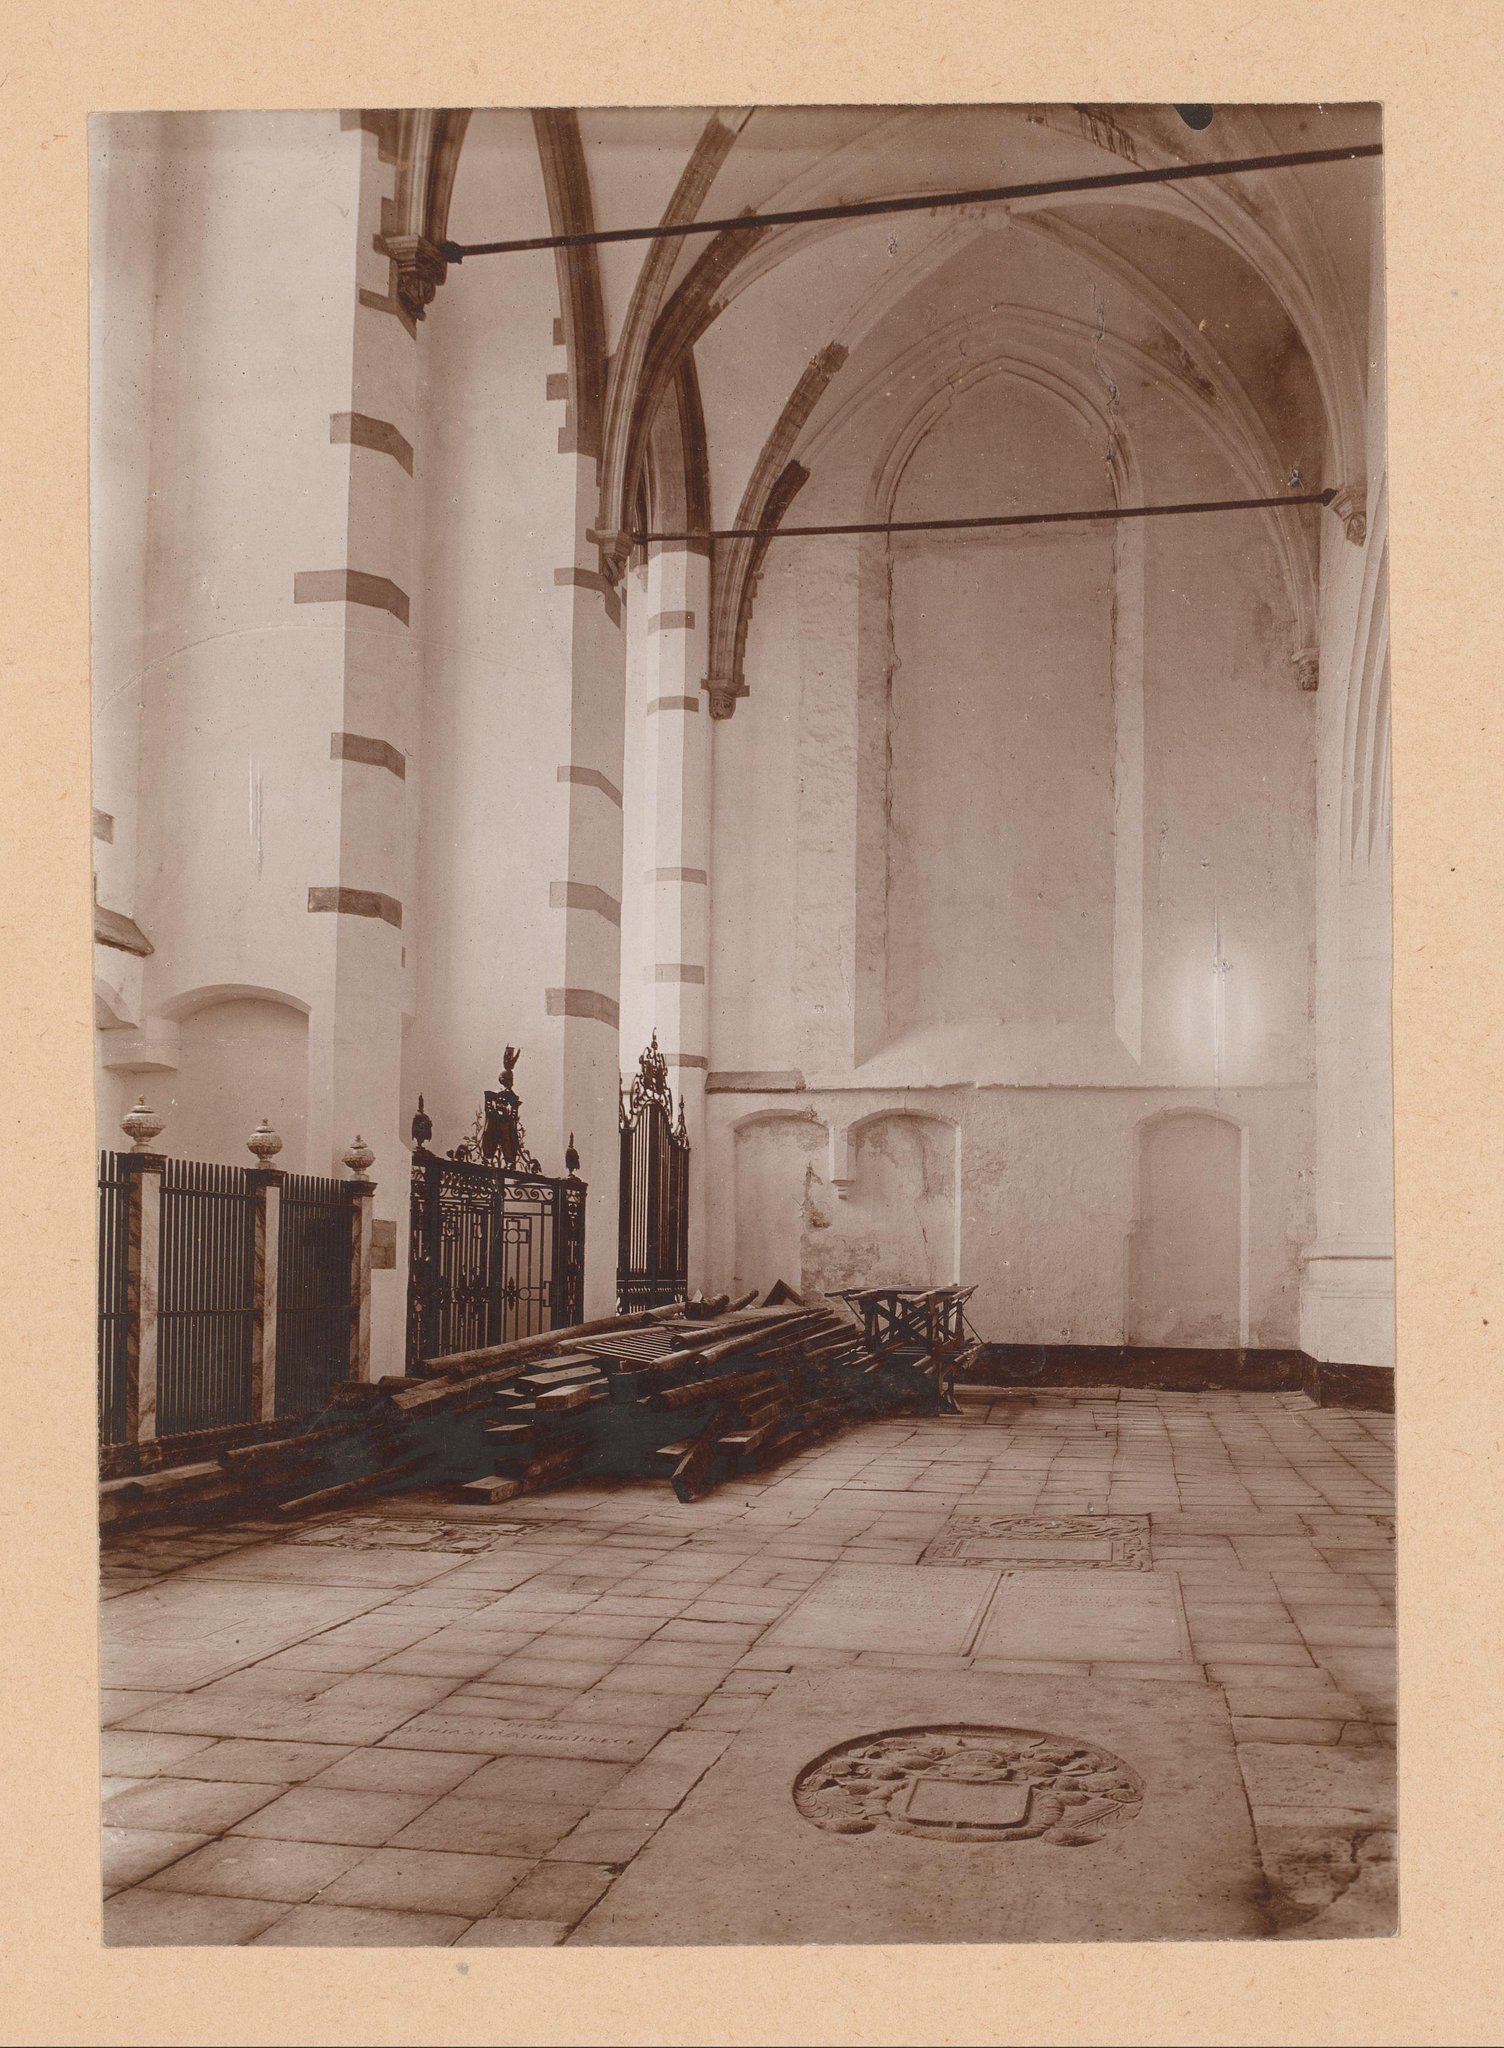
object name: photograph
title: Interieur van de Grote of Sint-Catharijnekerk te Brielle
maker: anoniem (monumentenzorg)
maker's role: fotograaf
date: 1908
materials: cardboard, photographic support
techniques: collodion silver print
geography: grote of sint-catharijnekerk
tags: interior of church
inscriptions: annotation: ‘Kerk te Brielle april 1908/ geschenk van Gos de Voogt’, annotation: ‘Brielle/ de N.H. Kerk (H. Catharina) den Briel’, annotation: ‘Kerk te Brielle/ April 1908/ Geschenk van Gos de Voogt’